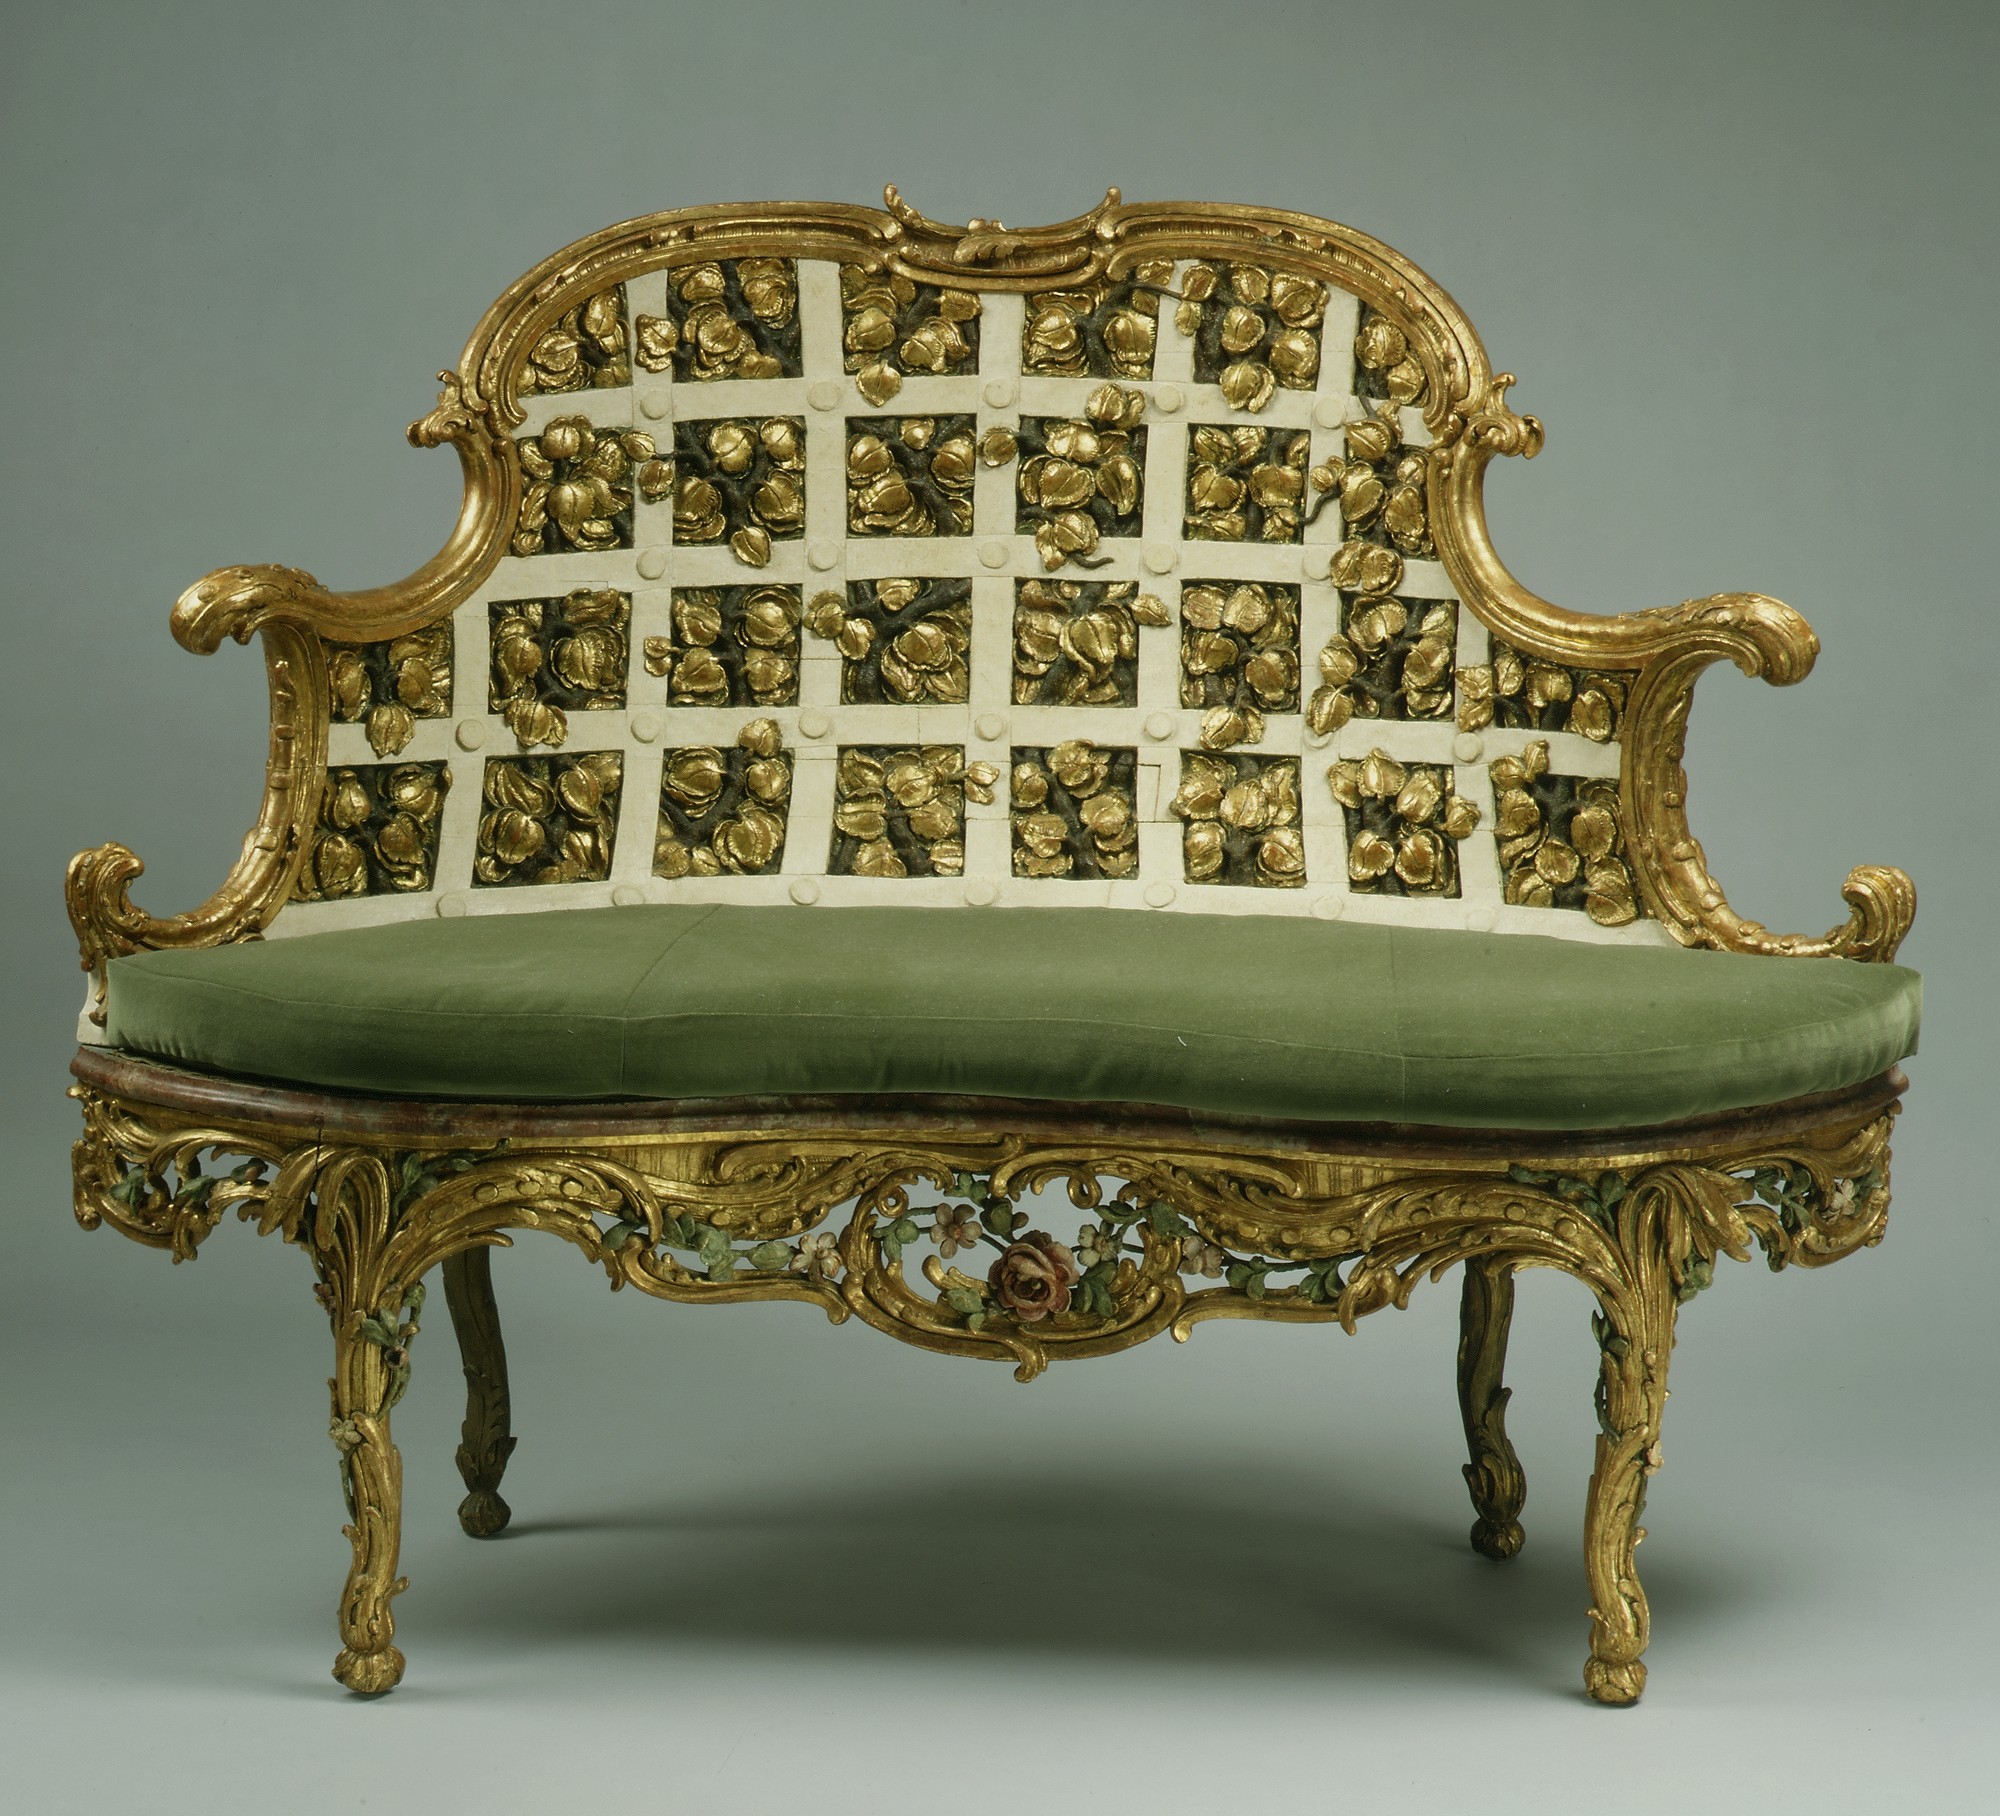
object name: settee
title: Settee (one of a pair) (part of a set)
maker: johann michael bauer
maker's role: maker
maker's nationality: german, born westheim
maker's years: 1710-1779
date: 1763-1764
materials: wood, silk, velvet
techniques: carving, gilding, painting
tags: flowers